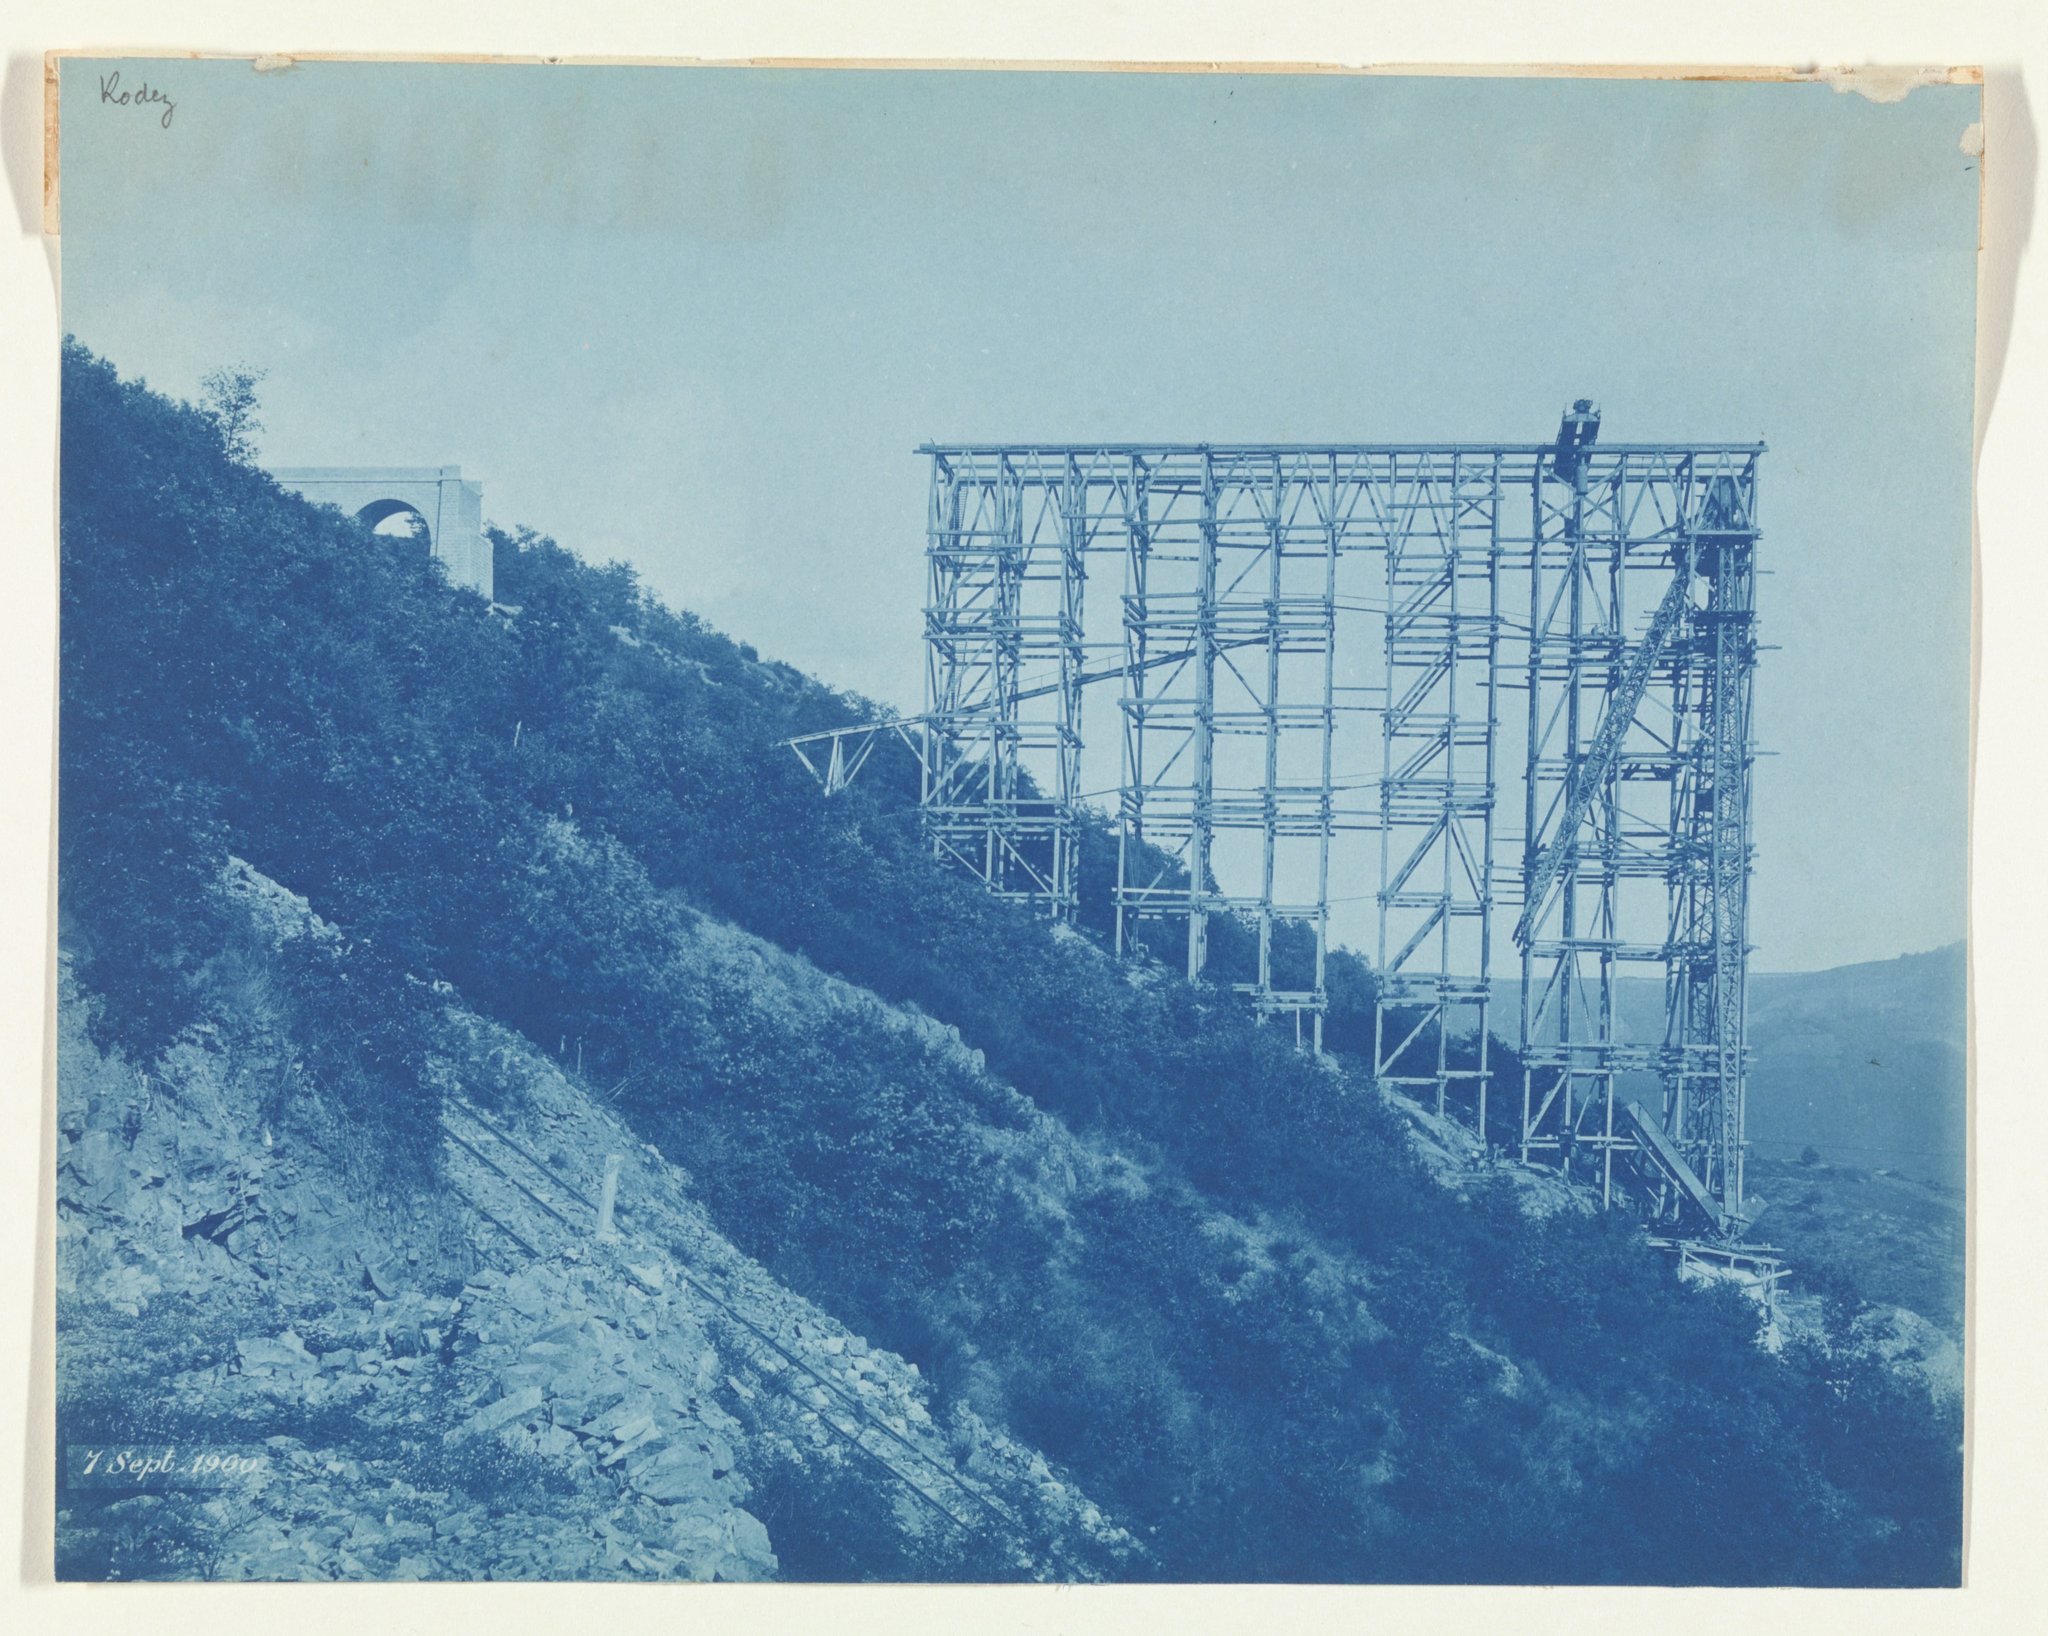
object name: photograph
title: Aanleg van het Viaur Viaduct in Frankrijk door de Societé de Construction des Battignolles, 7 september 1900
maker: Anonymous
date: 1900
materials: photographic support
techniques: cyanotype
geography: france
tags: viaduct, making the overground structures (~ building activities)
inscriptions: inscription: ‘Rodez’